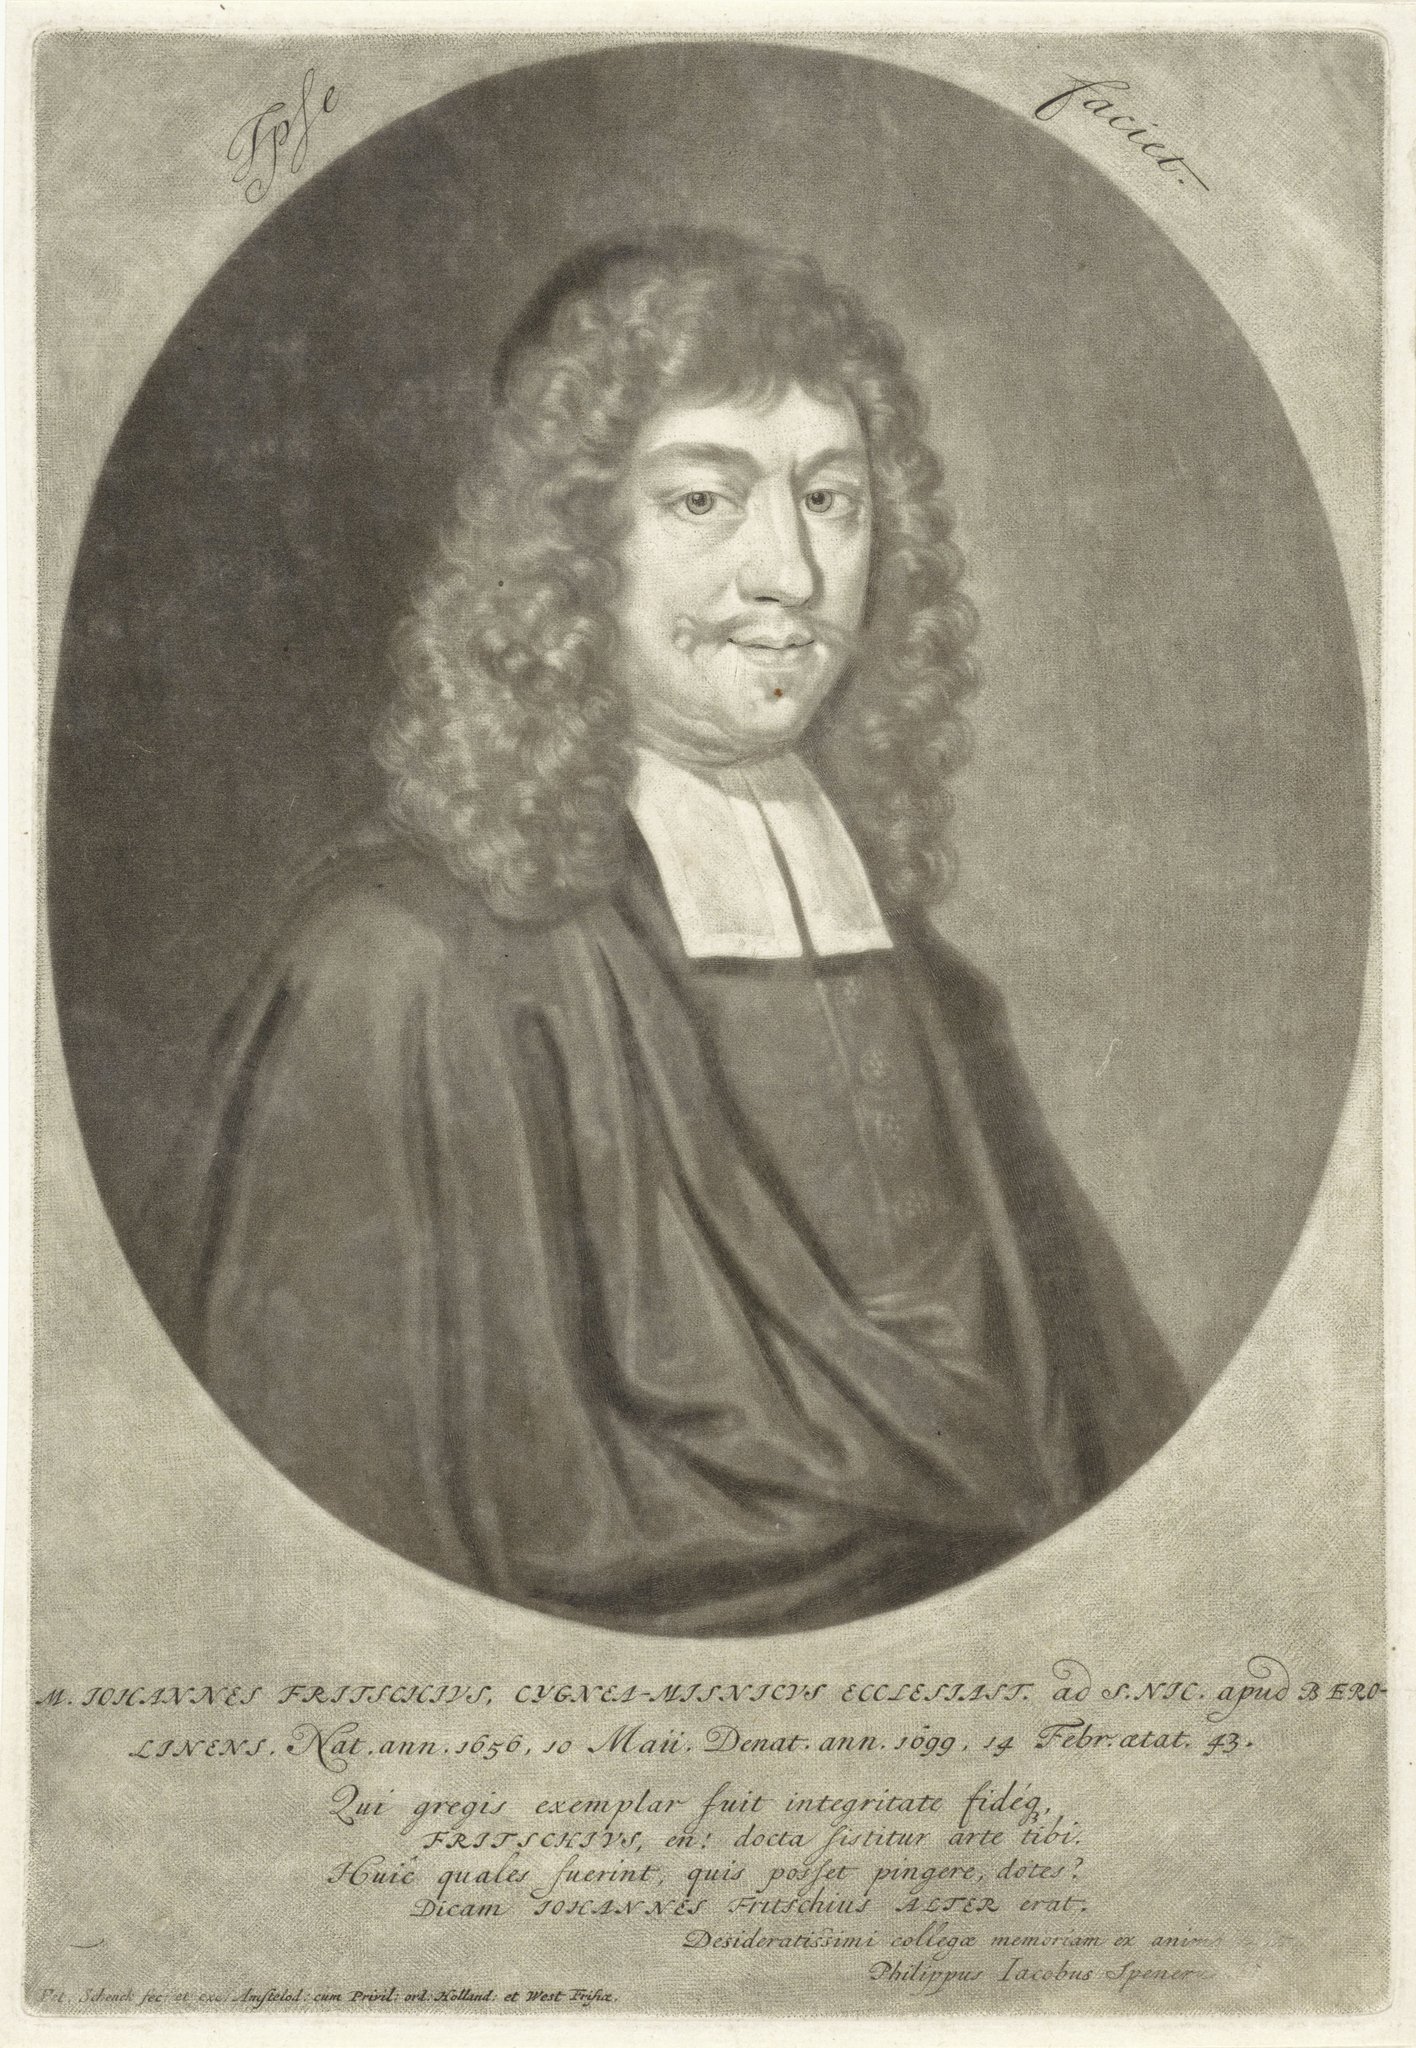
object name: print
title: Portret van de predikant Johannes Fritsch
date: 1699-1713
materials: paper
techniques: mezzotint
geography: amsterdam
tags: predikant, johannes fritsch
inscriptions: collector's mark: Lugt 2228